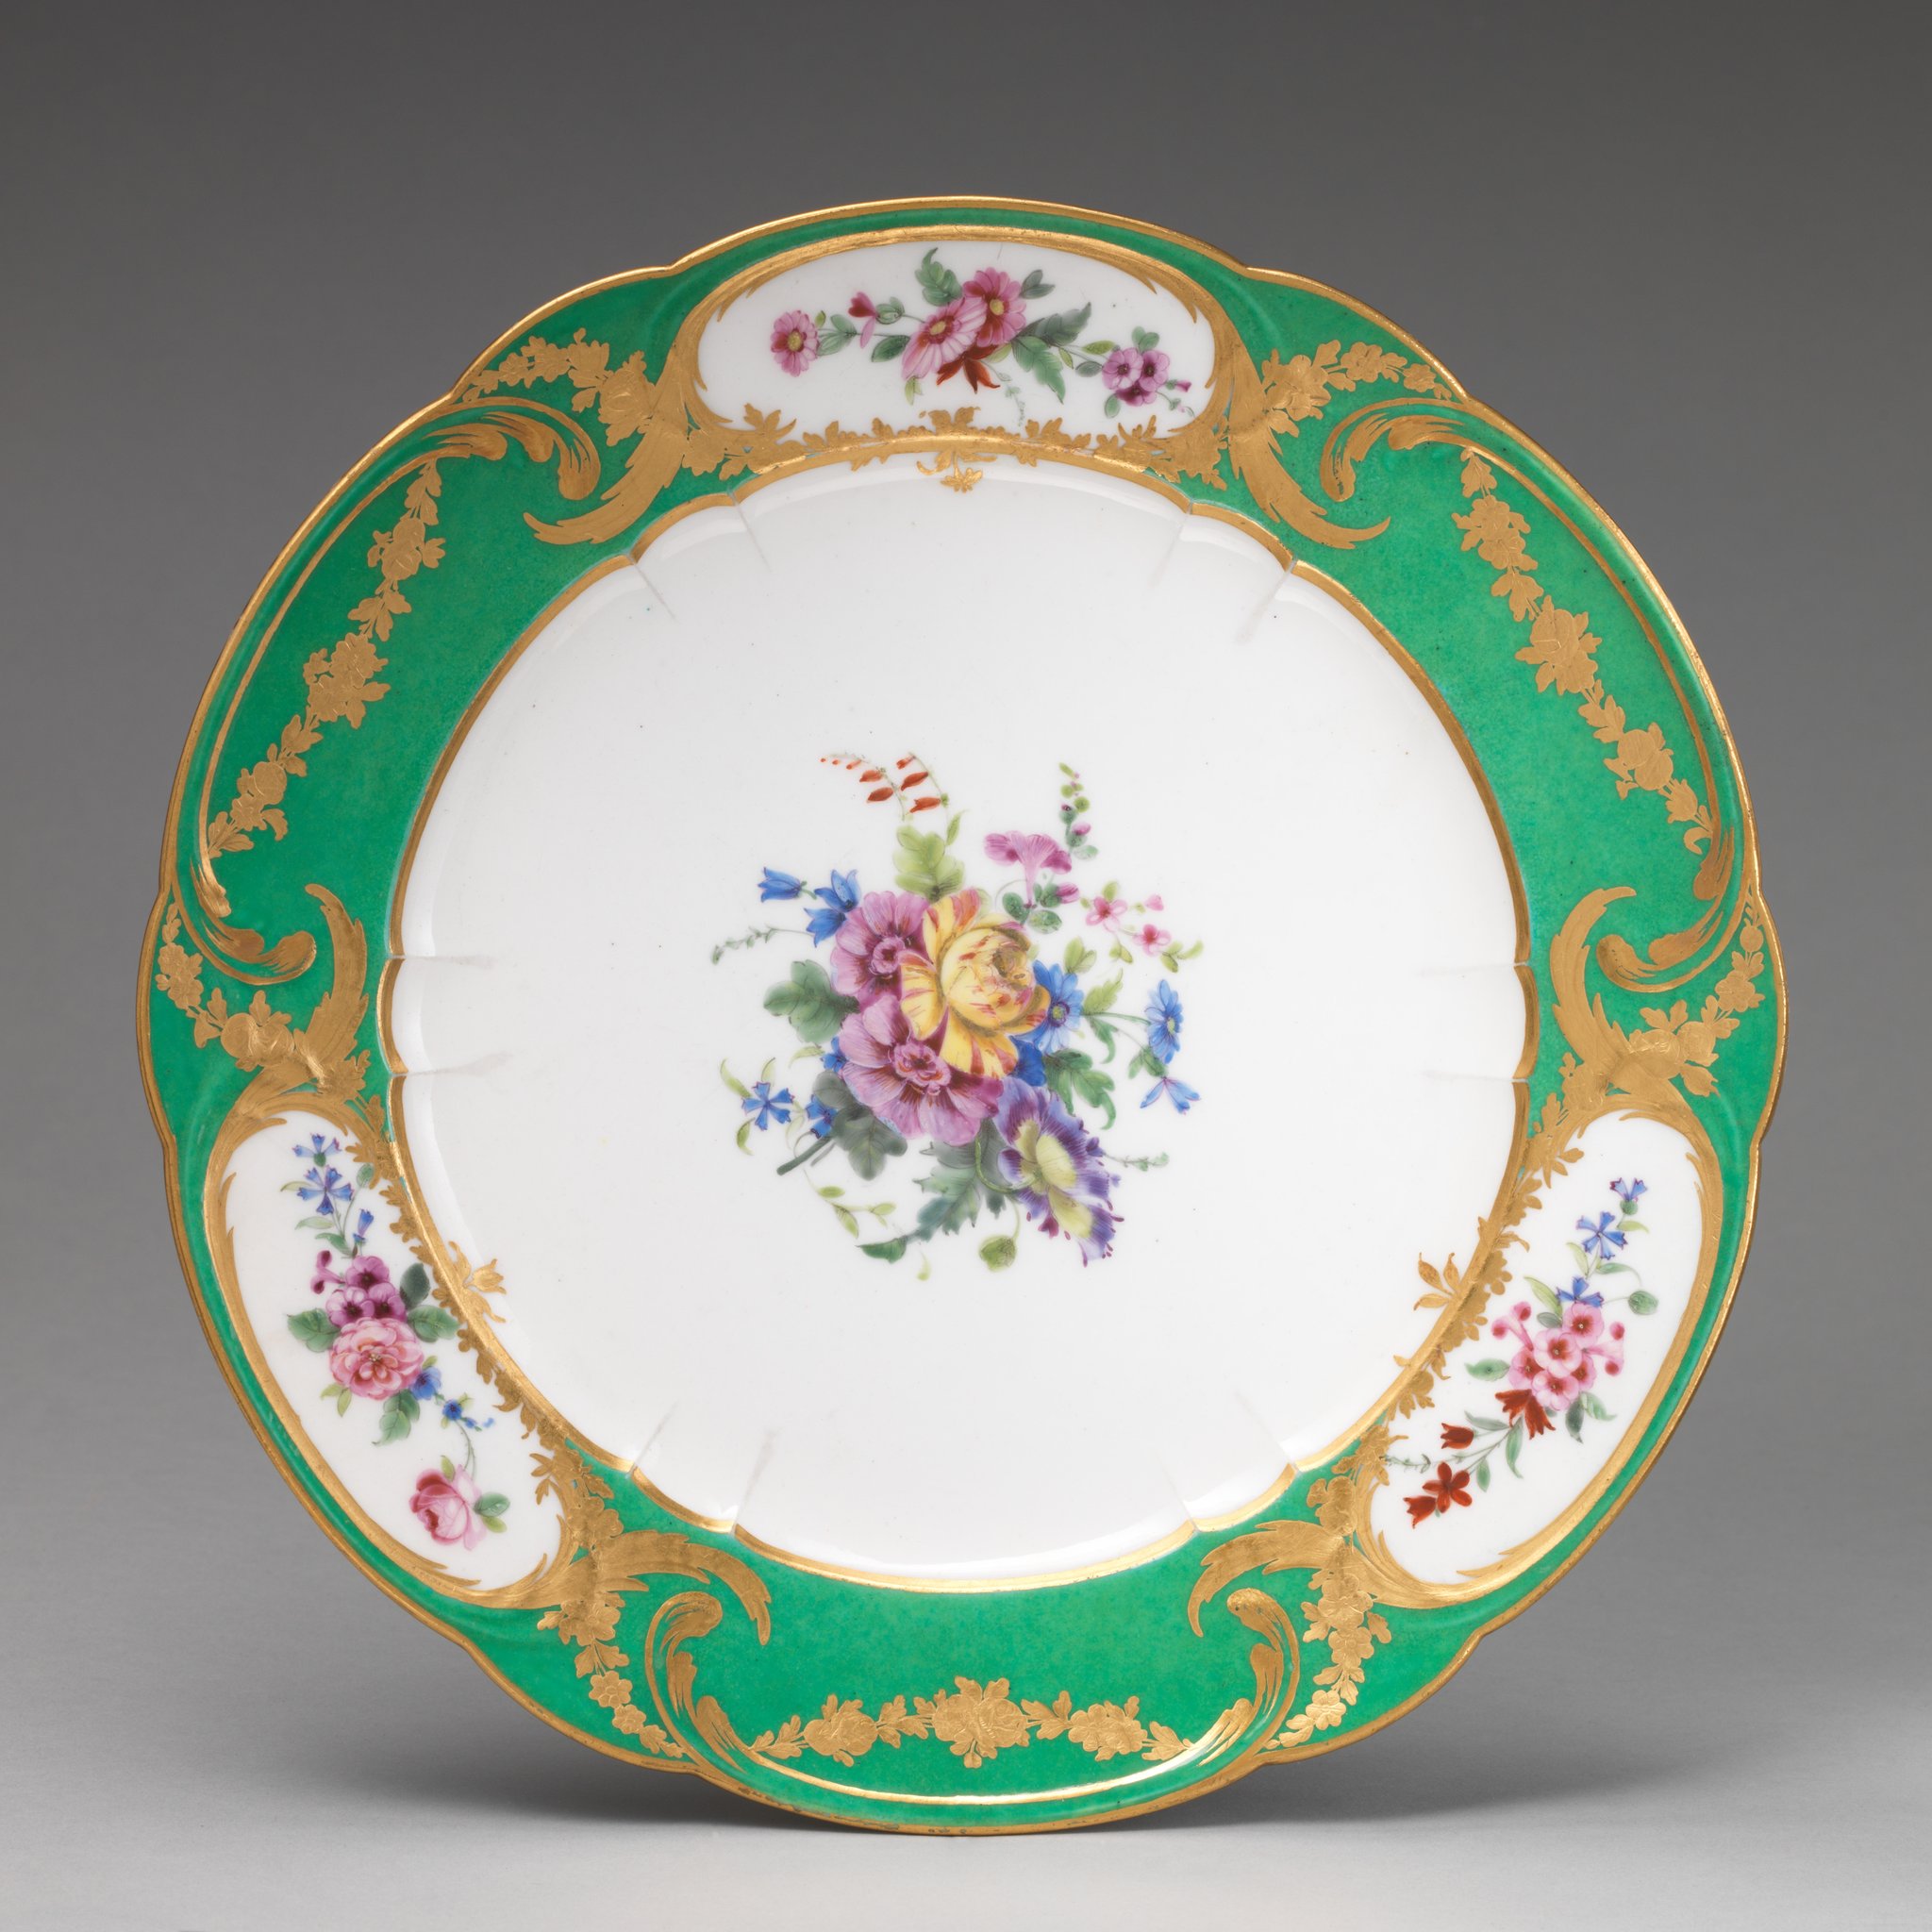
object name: plate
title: Plate (assiette à palmes) (1 of 102) (part of a service)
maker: sèvres manufactory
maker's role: manufactory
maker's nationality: french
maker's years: 1740-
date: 1780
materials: soft paste porcelain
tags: flowers